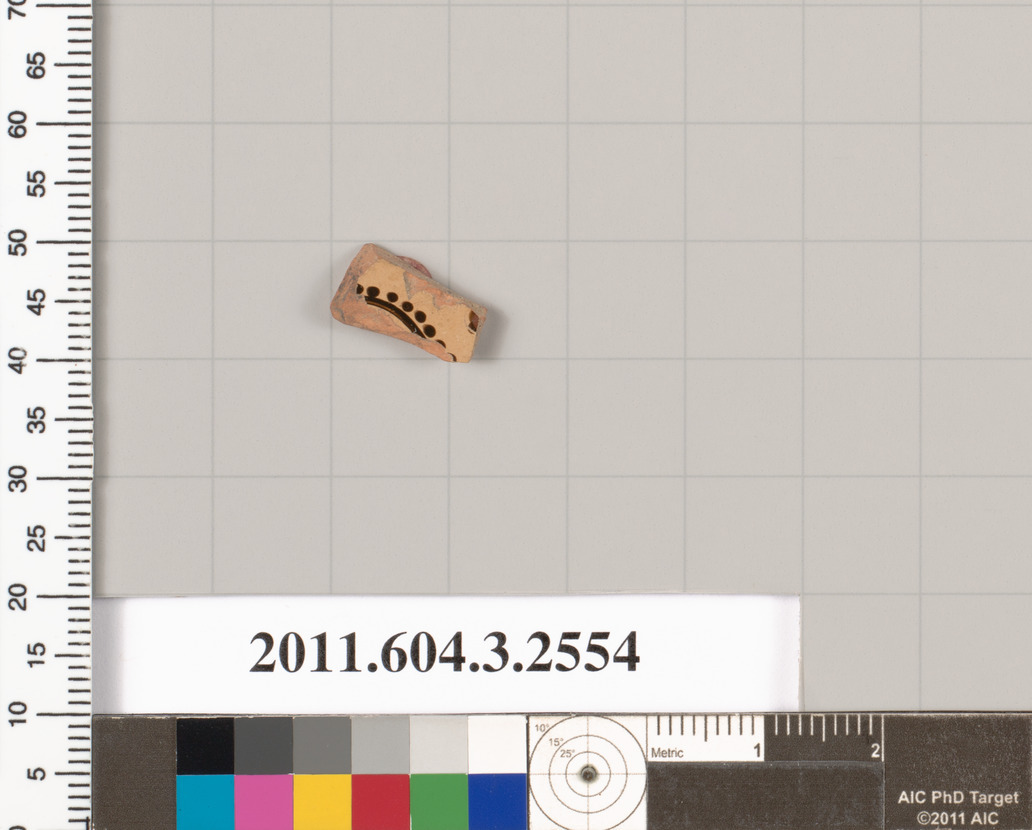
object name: kylix fragment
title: Terracotta fragment of a kylix (drinking cup)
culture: greek, attic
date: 534-468 BCE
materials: terracotta